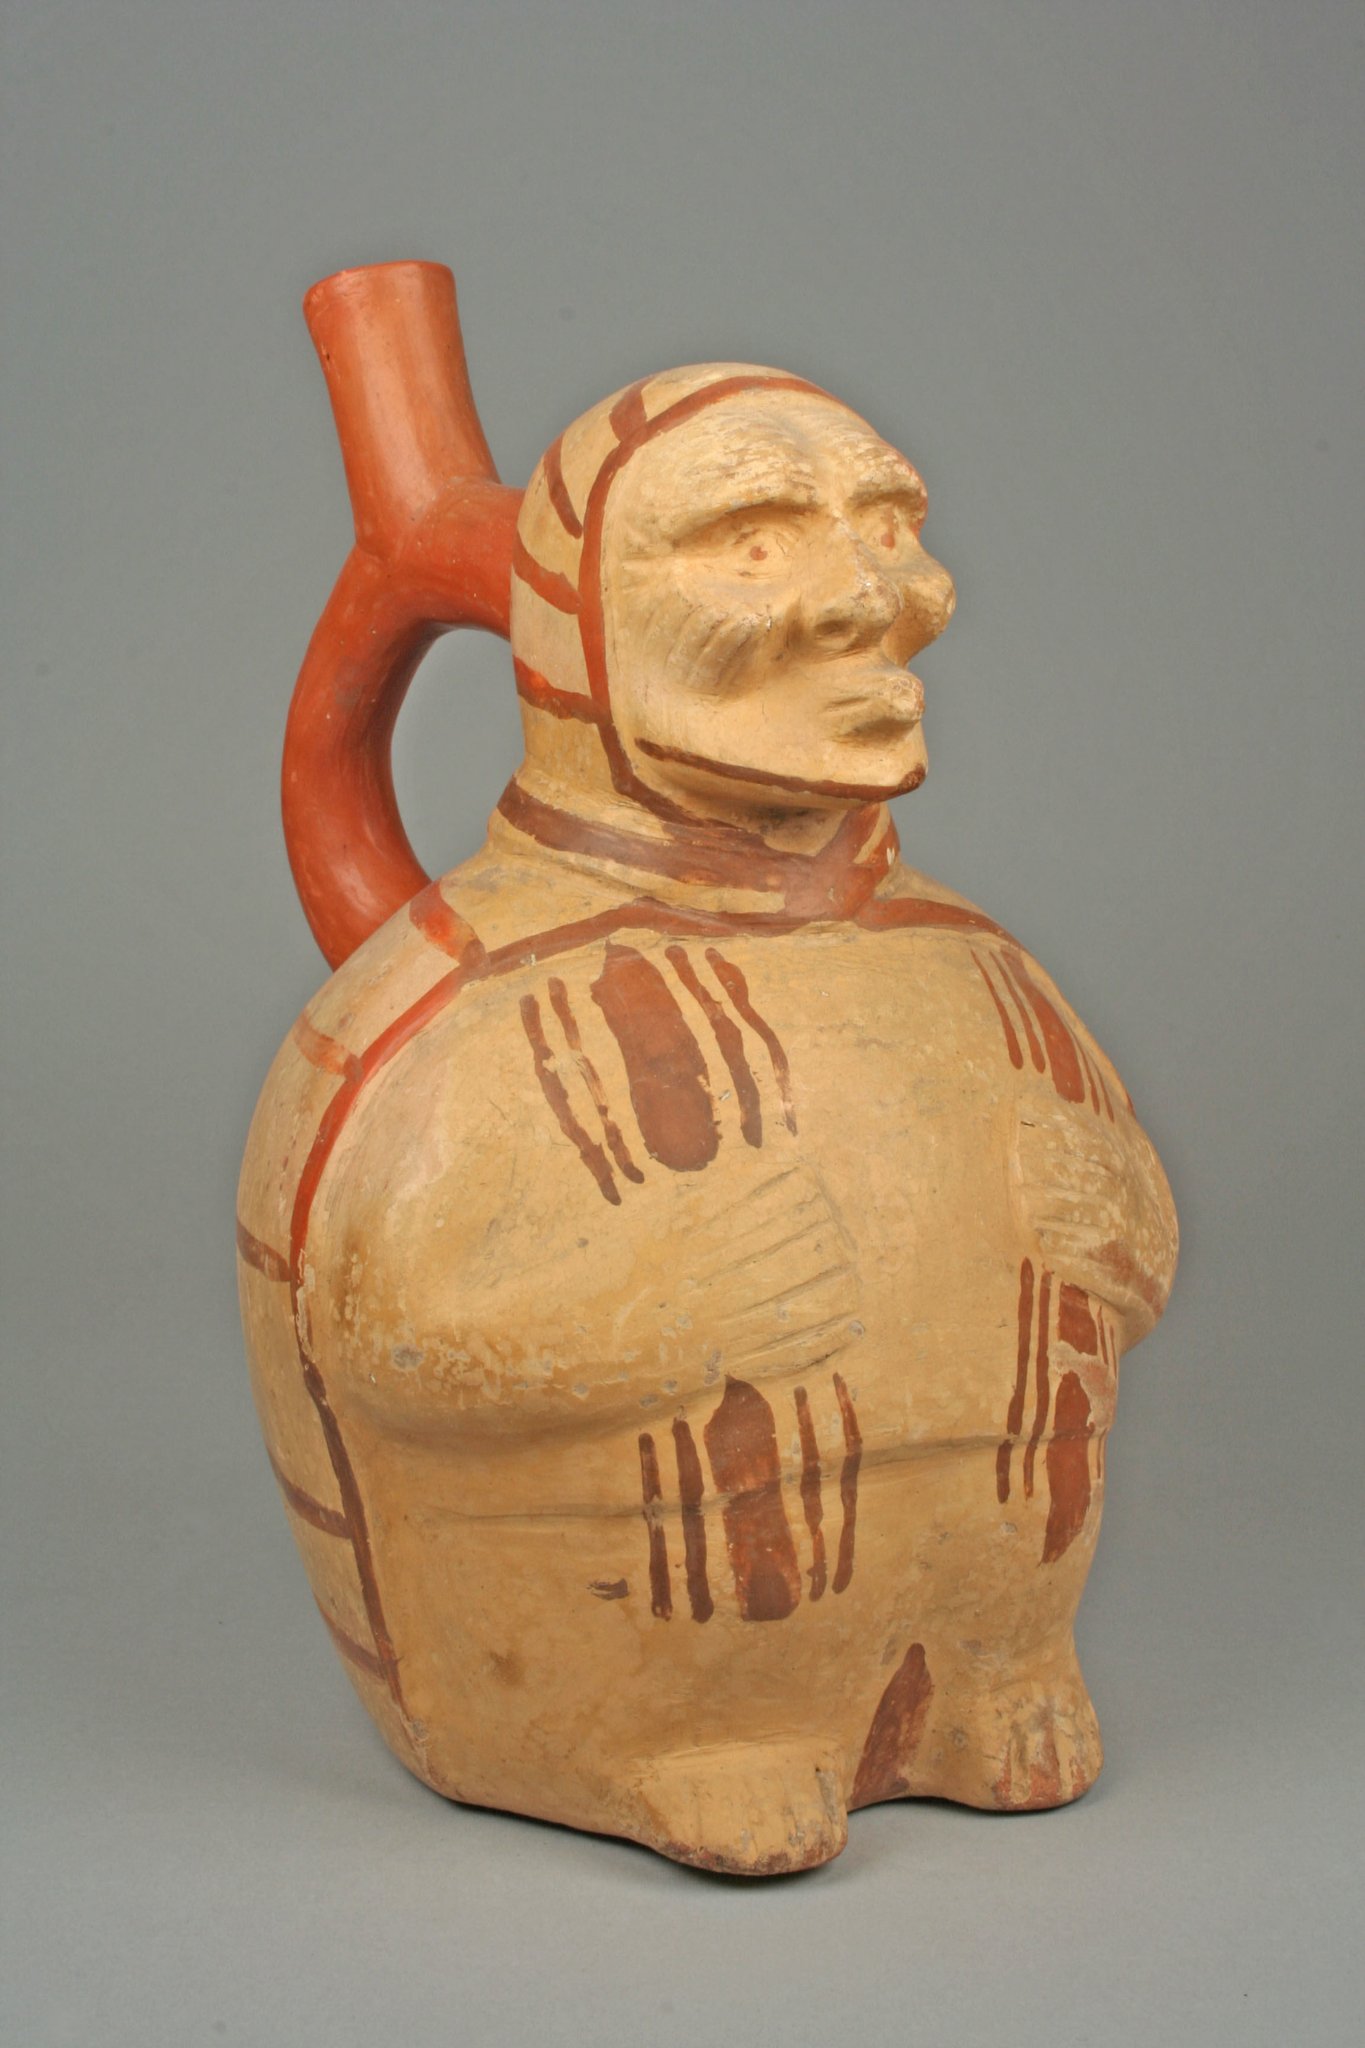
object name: bottle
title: Stirrup Spout Bottle with Figure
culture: moche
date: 101-500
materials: ceramic, pigment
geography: peru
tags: human figures